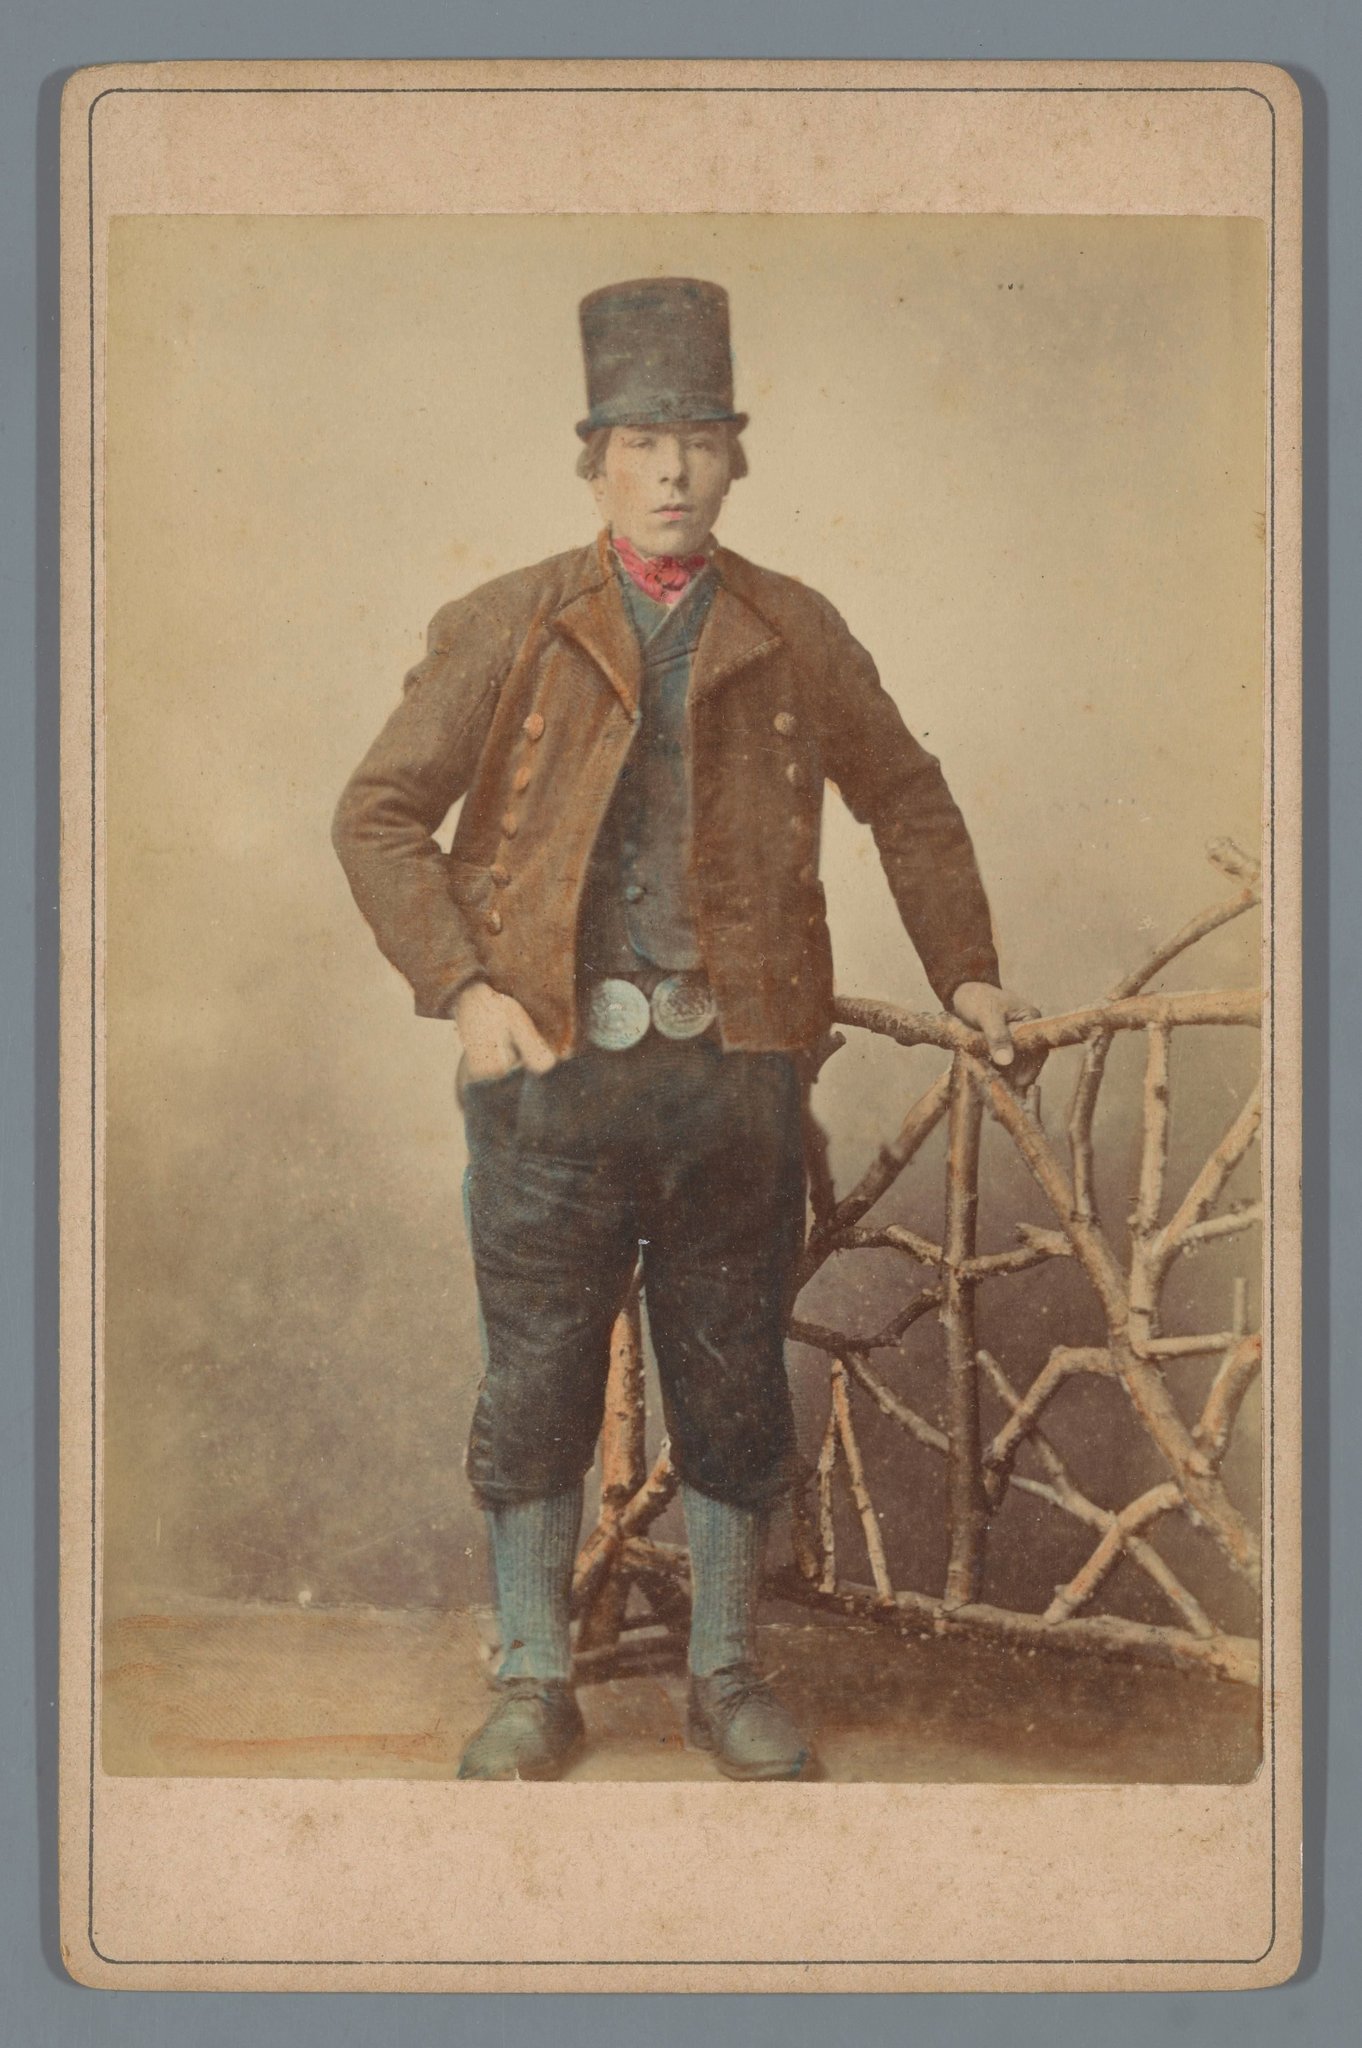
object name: cabinet photograph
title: Portret van een onbekende man in klederdracht van Walcheren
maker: Anonymous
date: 1870-1890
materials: cardboard, photographic support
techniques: albumen print, hand coloring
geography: netherlands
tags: studio requisites ~ photographer, folk costume, regional costume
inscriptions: name: ‘Boek-, Papier-en Kunsthandel Opgericht 1813. A. Van Hoogstraten &Zn. Hofleveranciers, PLaats 11, - 's Hage’, inscription: ‘Walcheren’